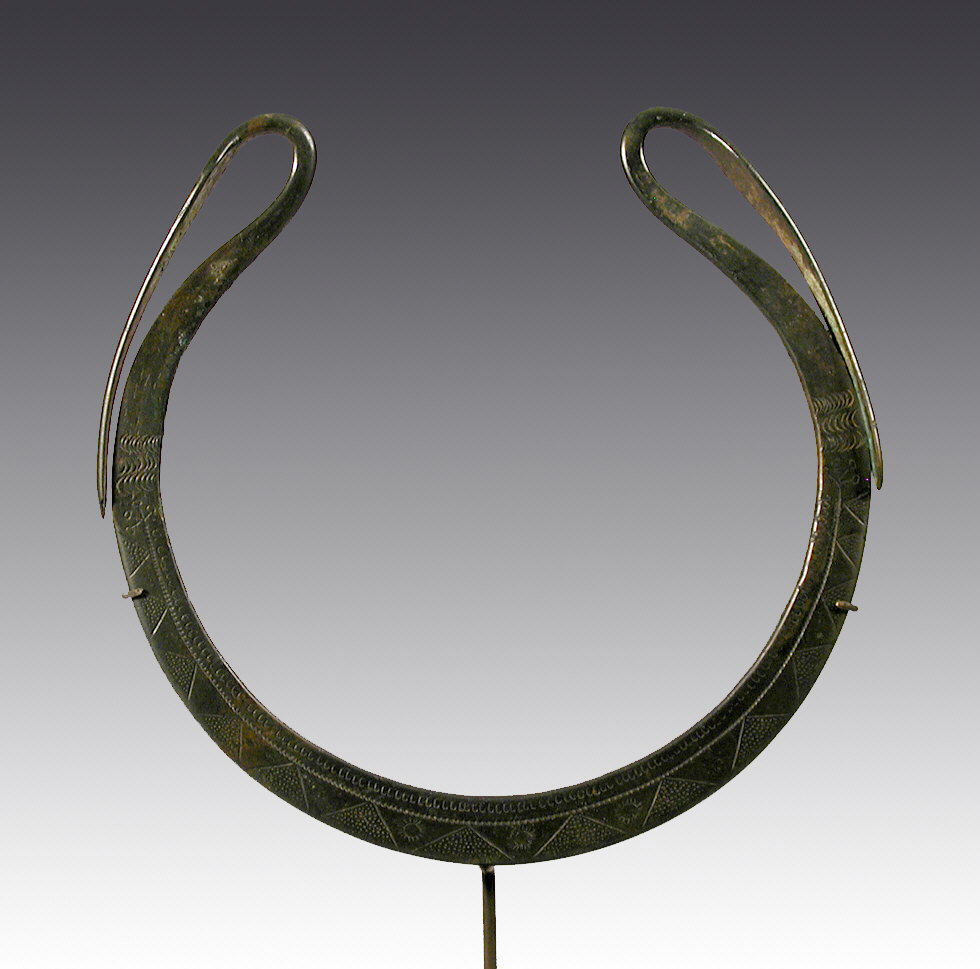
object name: torc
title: Neck Ring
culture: celtic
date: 500-300 BCE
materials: bronze